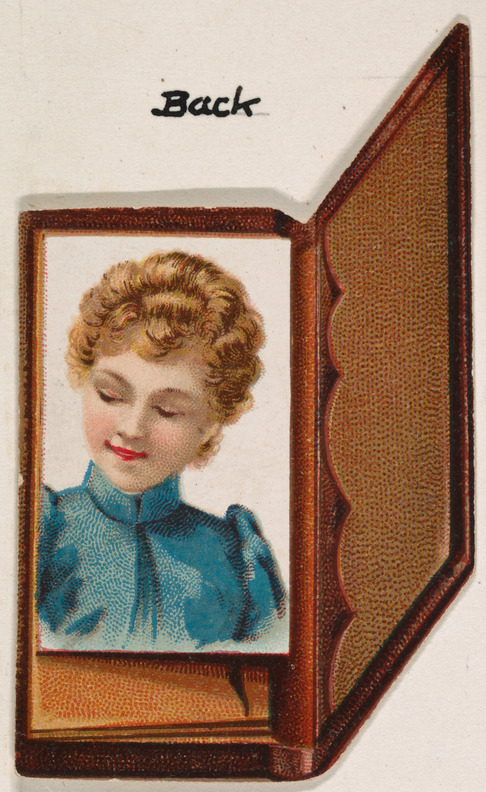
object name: print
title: Billfold, from the Novelties series (N228, Type 3) issued by Kinney Bros.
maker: kinney brothers tobacco company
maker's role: publisher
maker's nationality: american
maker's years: 1869-2011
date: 1889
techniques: color lithograph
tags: women